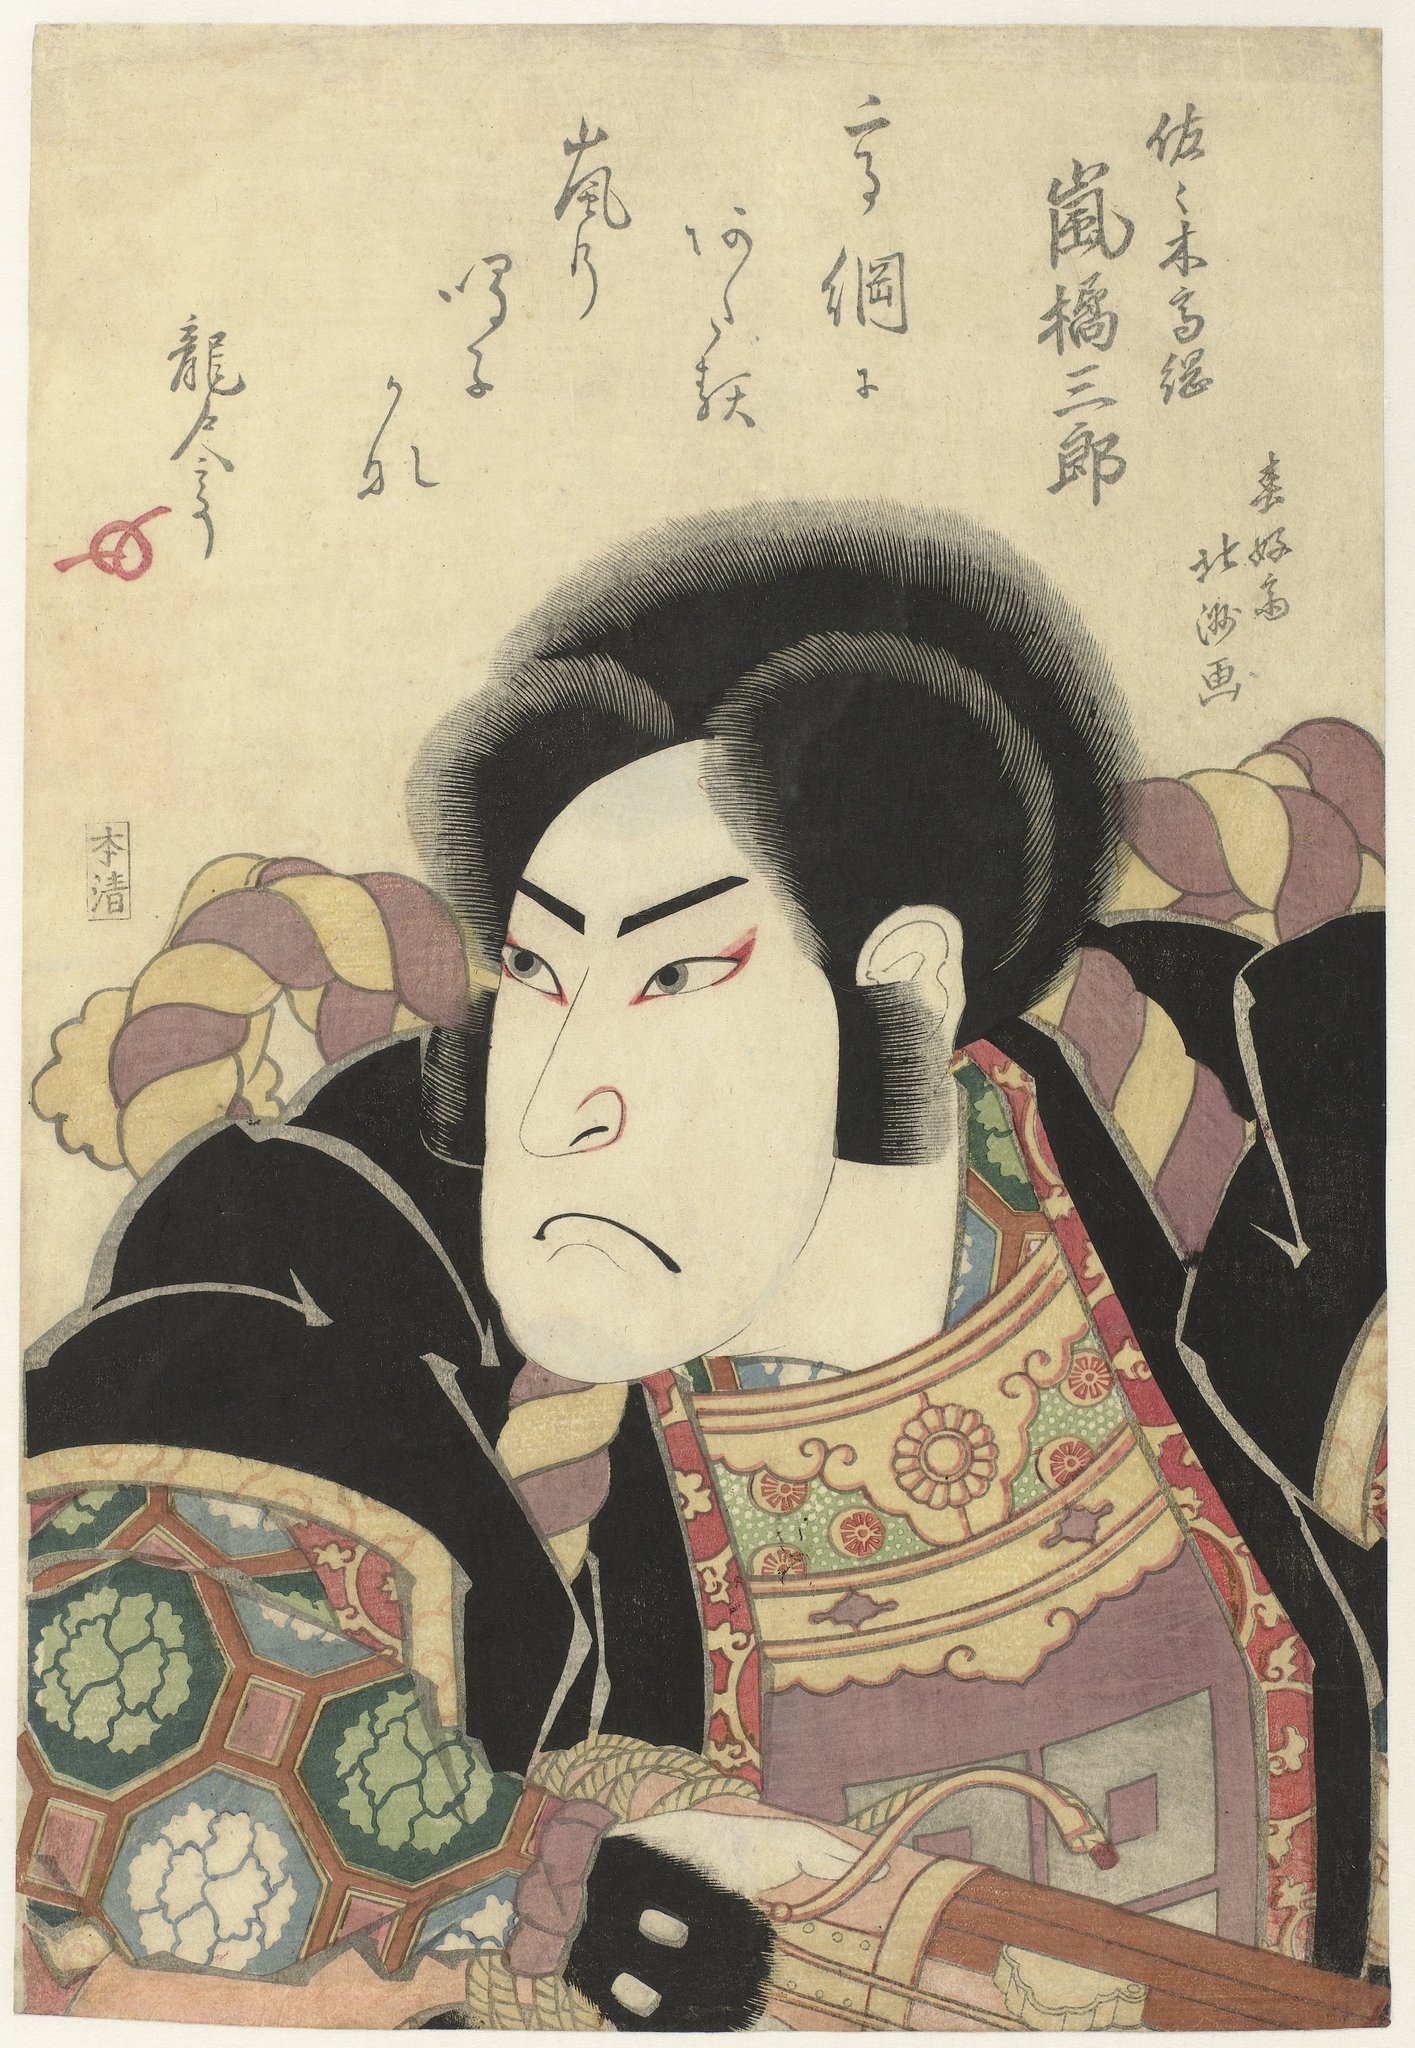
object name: print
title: Arashi Kitsusaburô I als Sasaki Takatsuna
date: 1810-1821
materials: paper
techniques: woodcut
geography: osaka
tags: actor (on the stage)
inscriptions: date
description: Toneelspeler Arashi Kitsusaburô I in de rol van Sasaki Takatsuna.